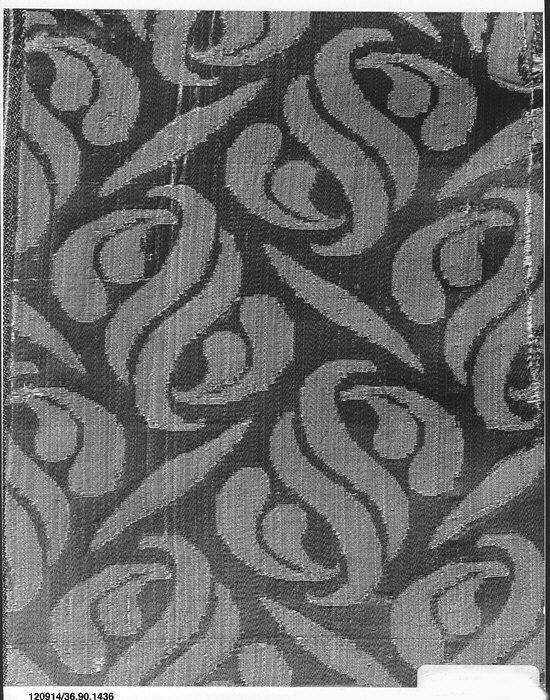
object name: piece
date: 1601-1700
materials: silk